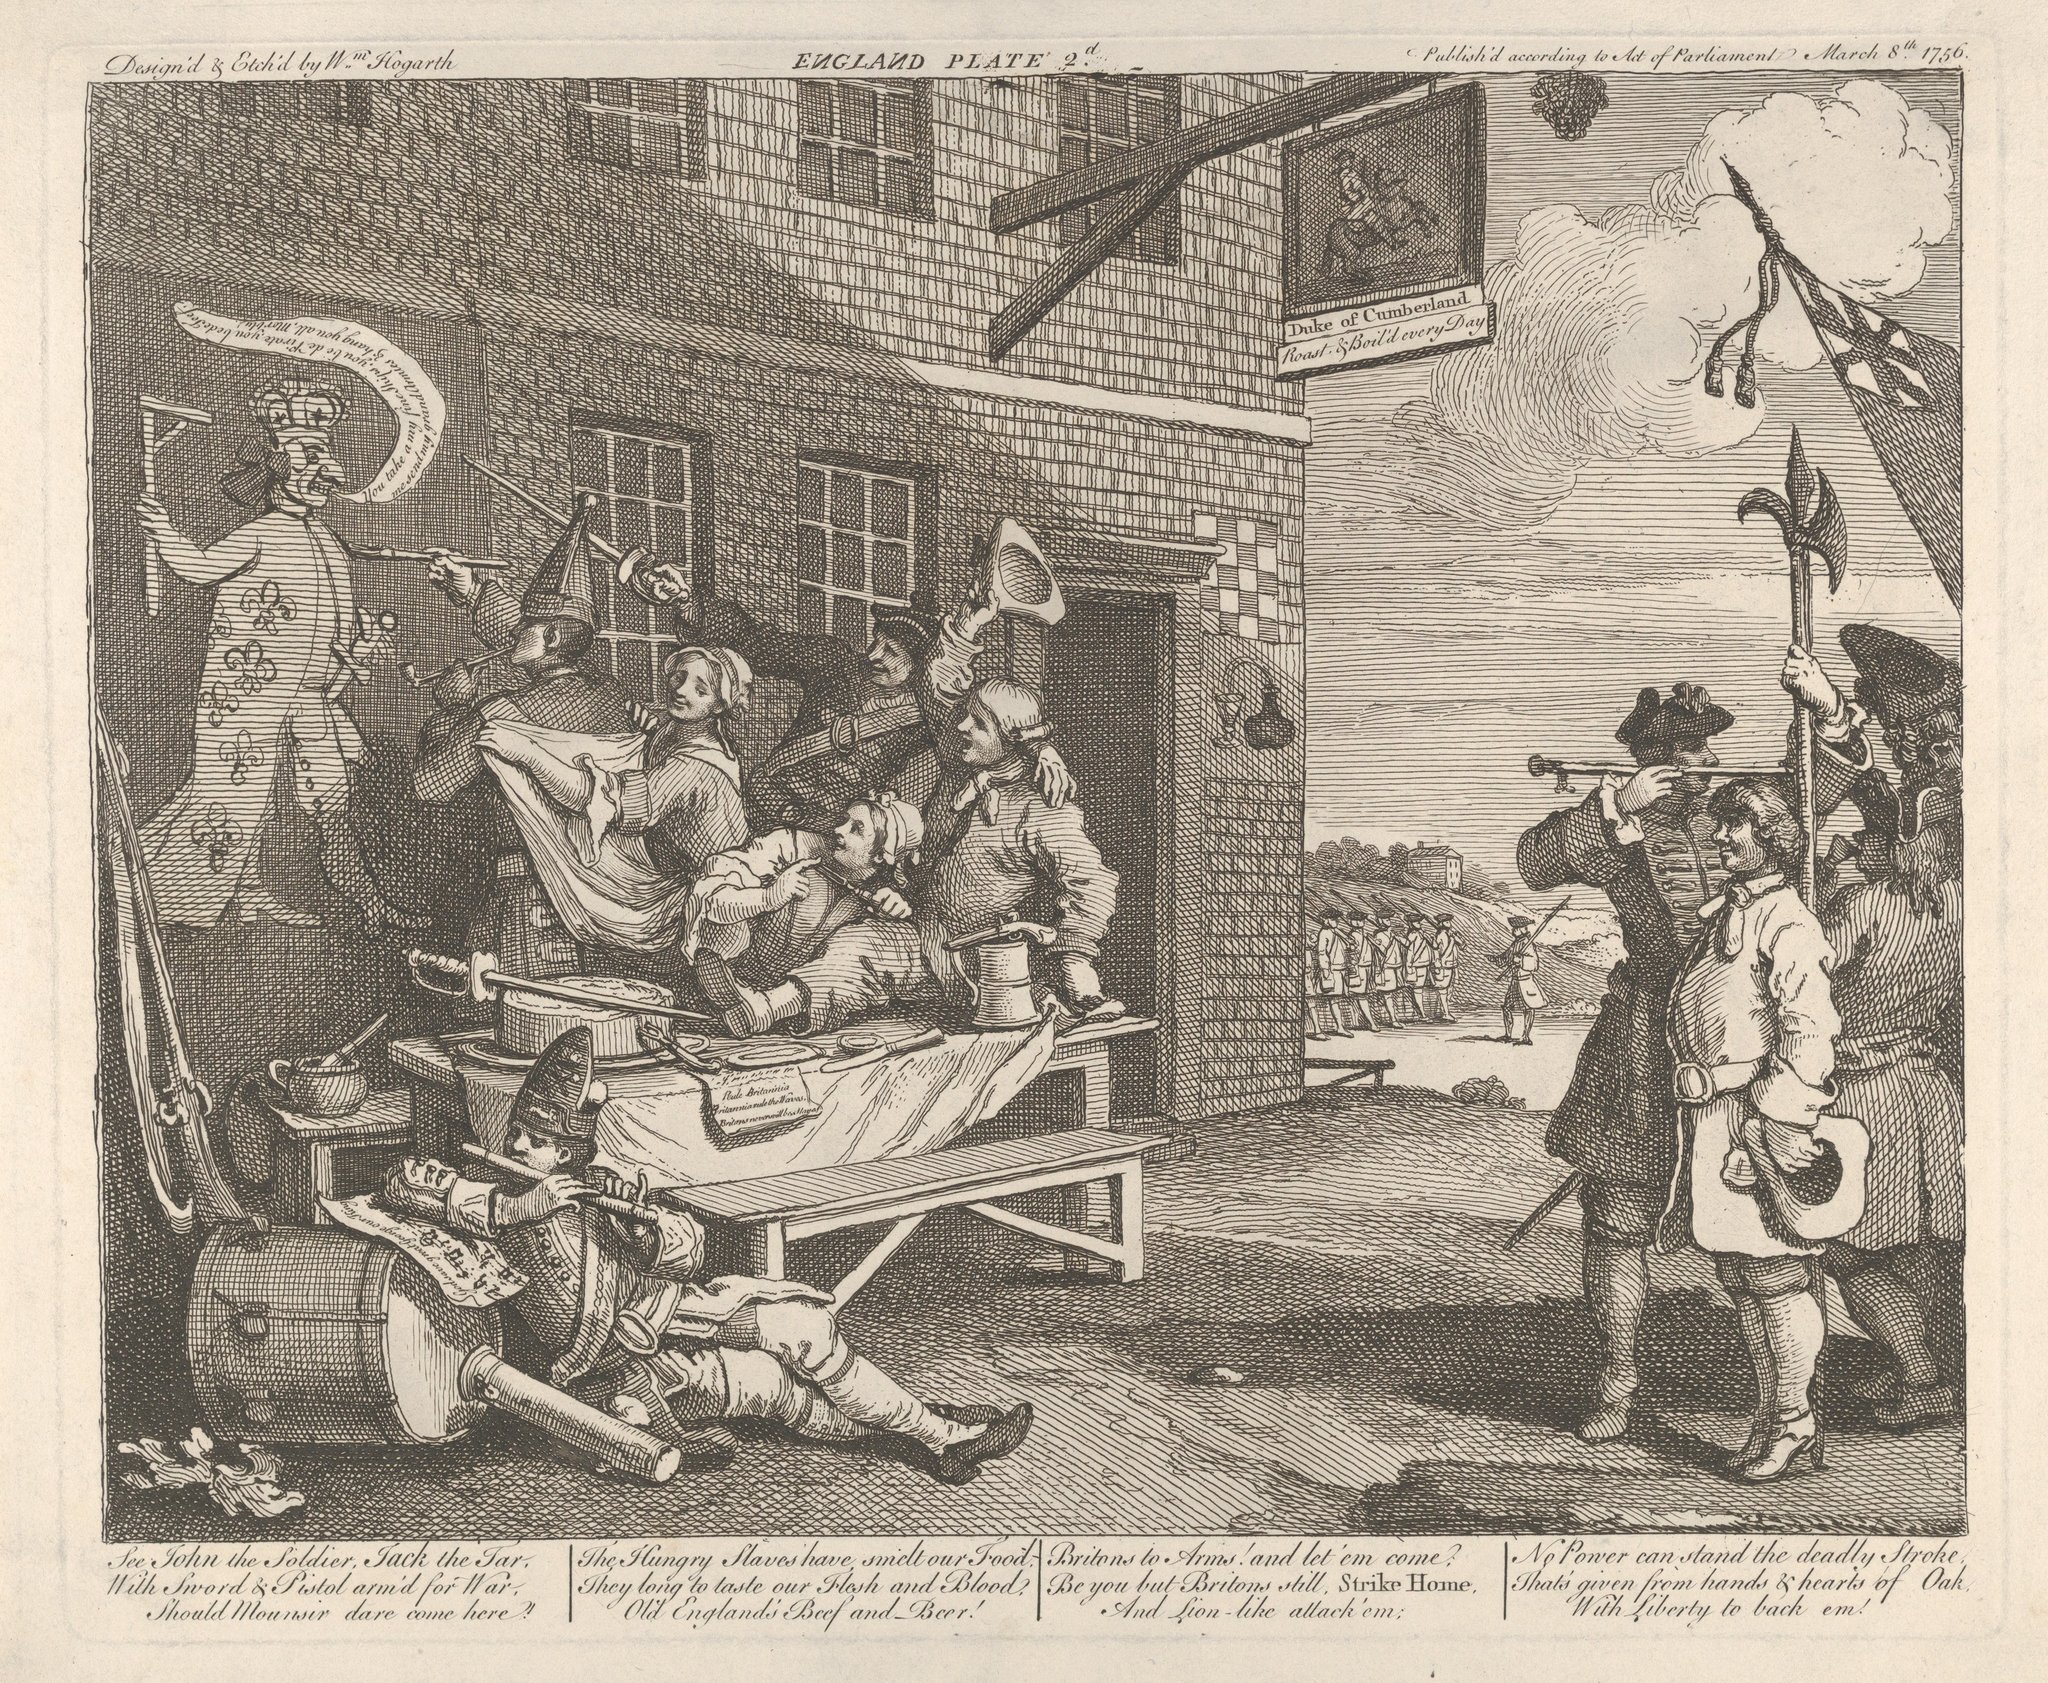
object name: print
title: The Invasion, Plate 2: England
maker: william hogarth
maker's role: artist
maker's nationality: british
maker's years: 1697-1764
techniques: etching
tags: buildings,soldiers,men,women